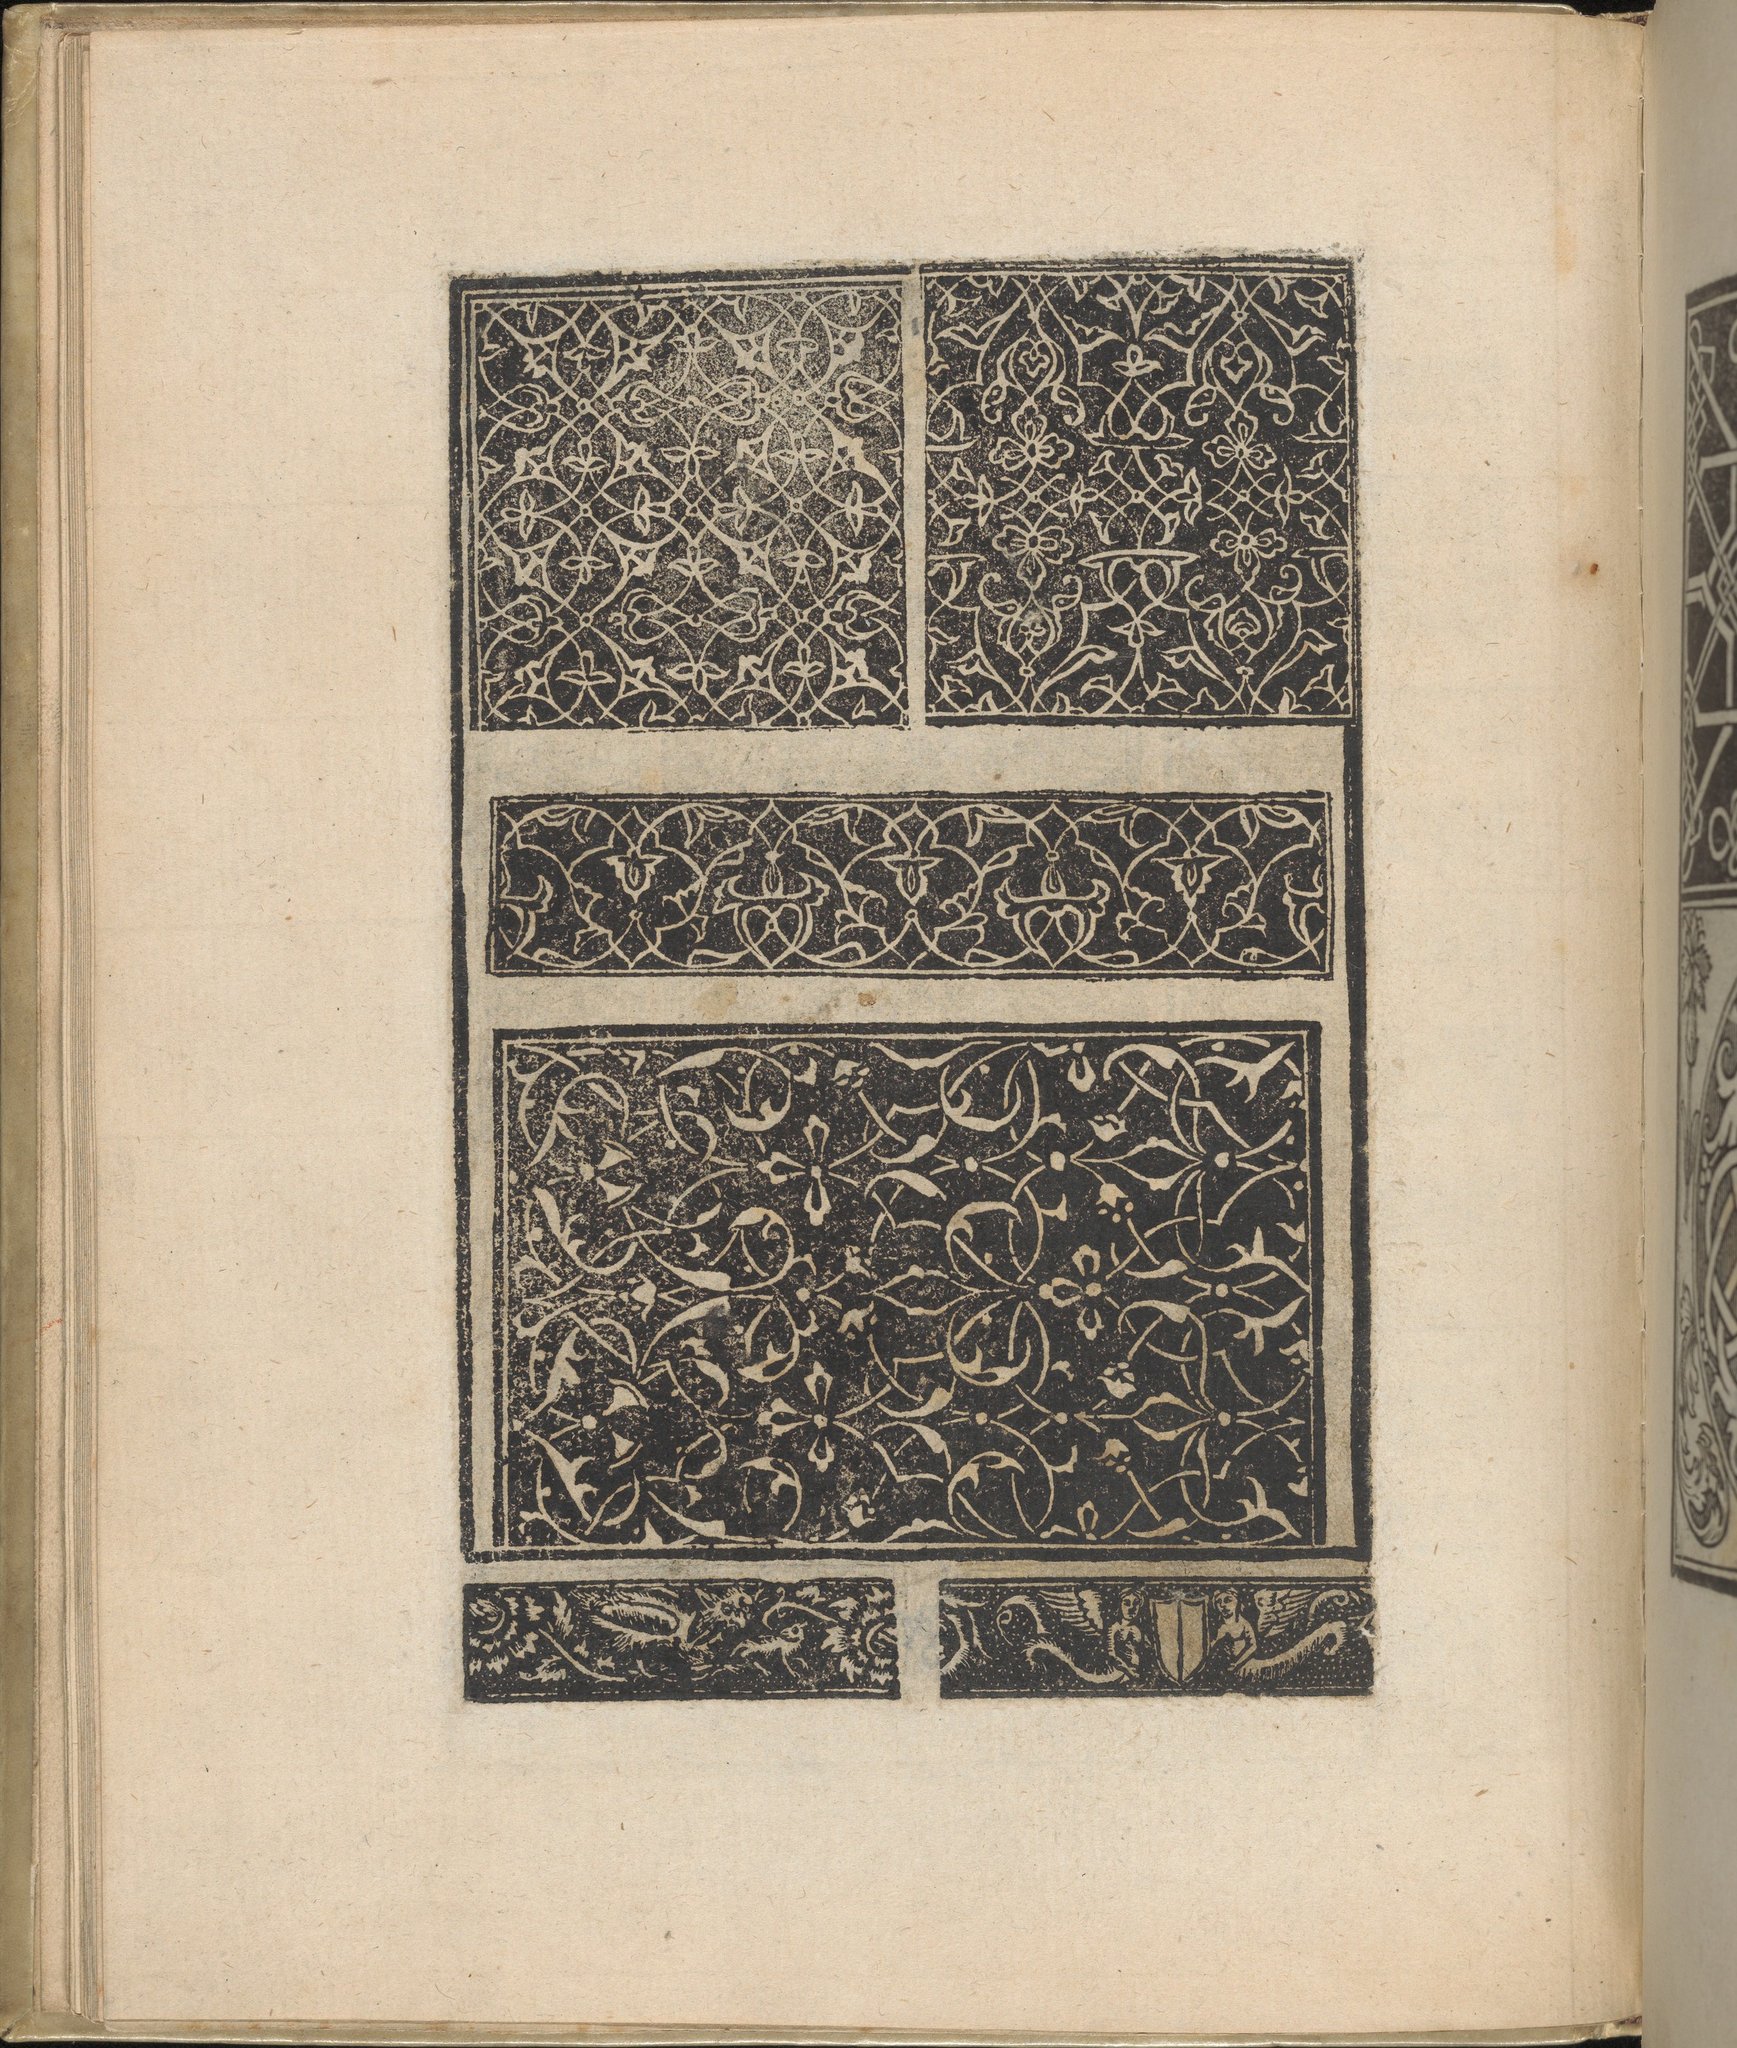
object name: book print ornament architecture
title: Trionfo Di Virtu. Libro Novo..., page 14 (recto)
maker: matteo pagano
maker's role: publisher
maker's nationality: italian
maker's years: 1515-1588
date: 1563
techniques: woodcut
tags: ornament,flowers